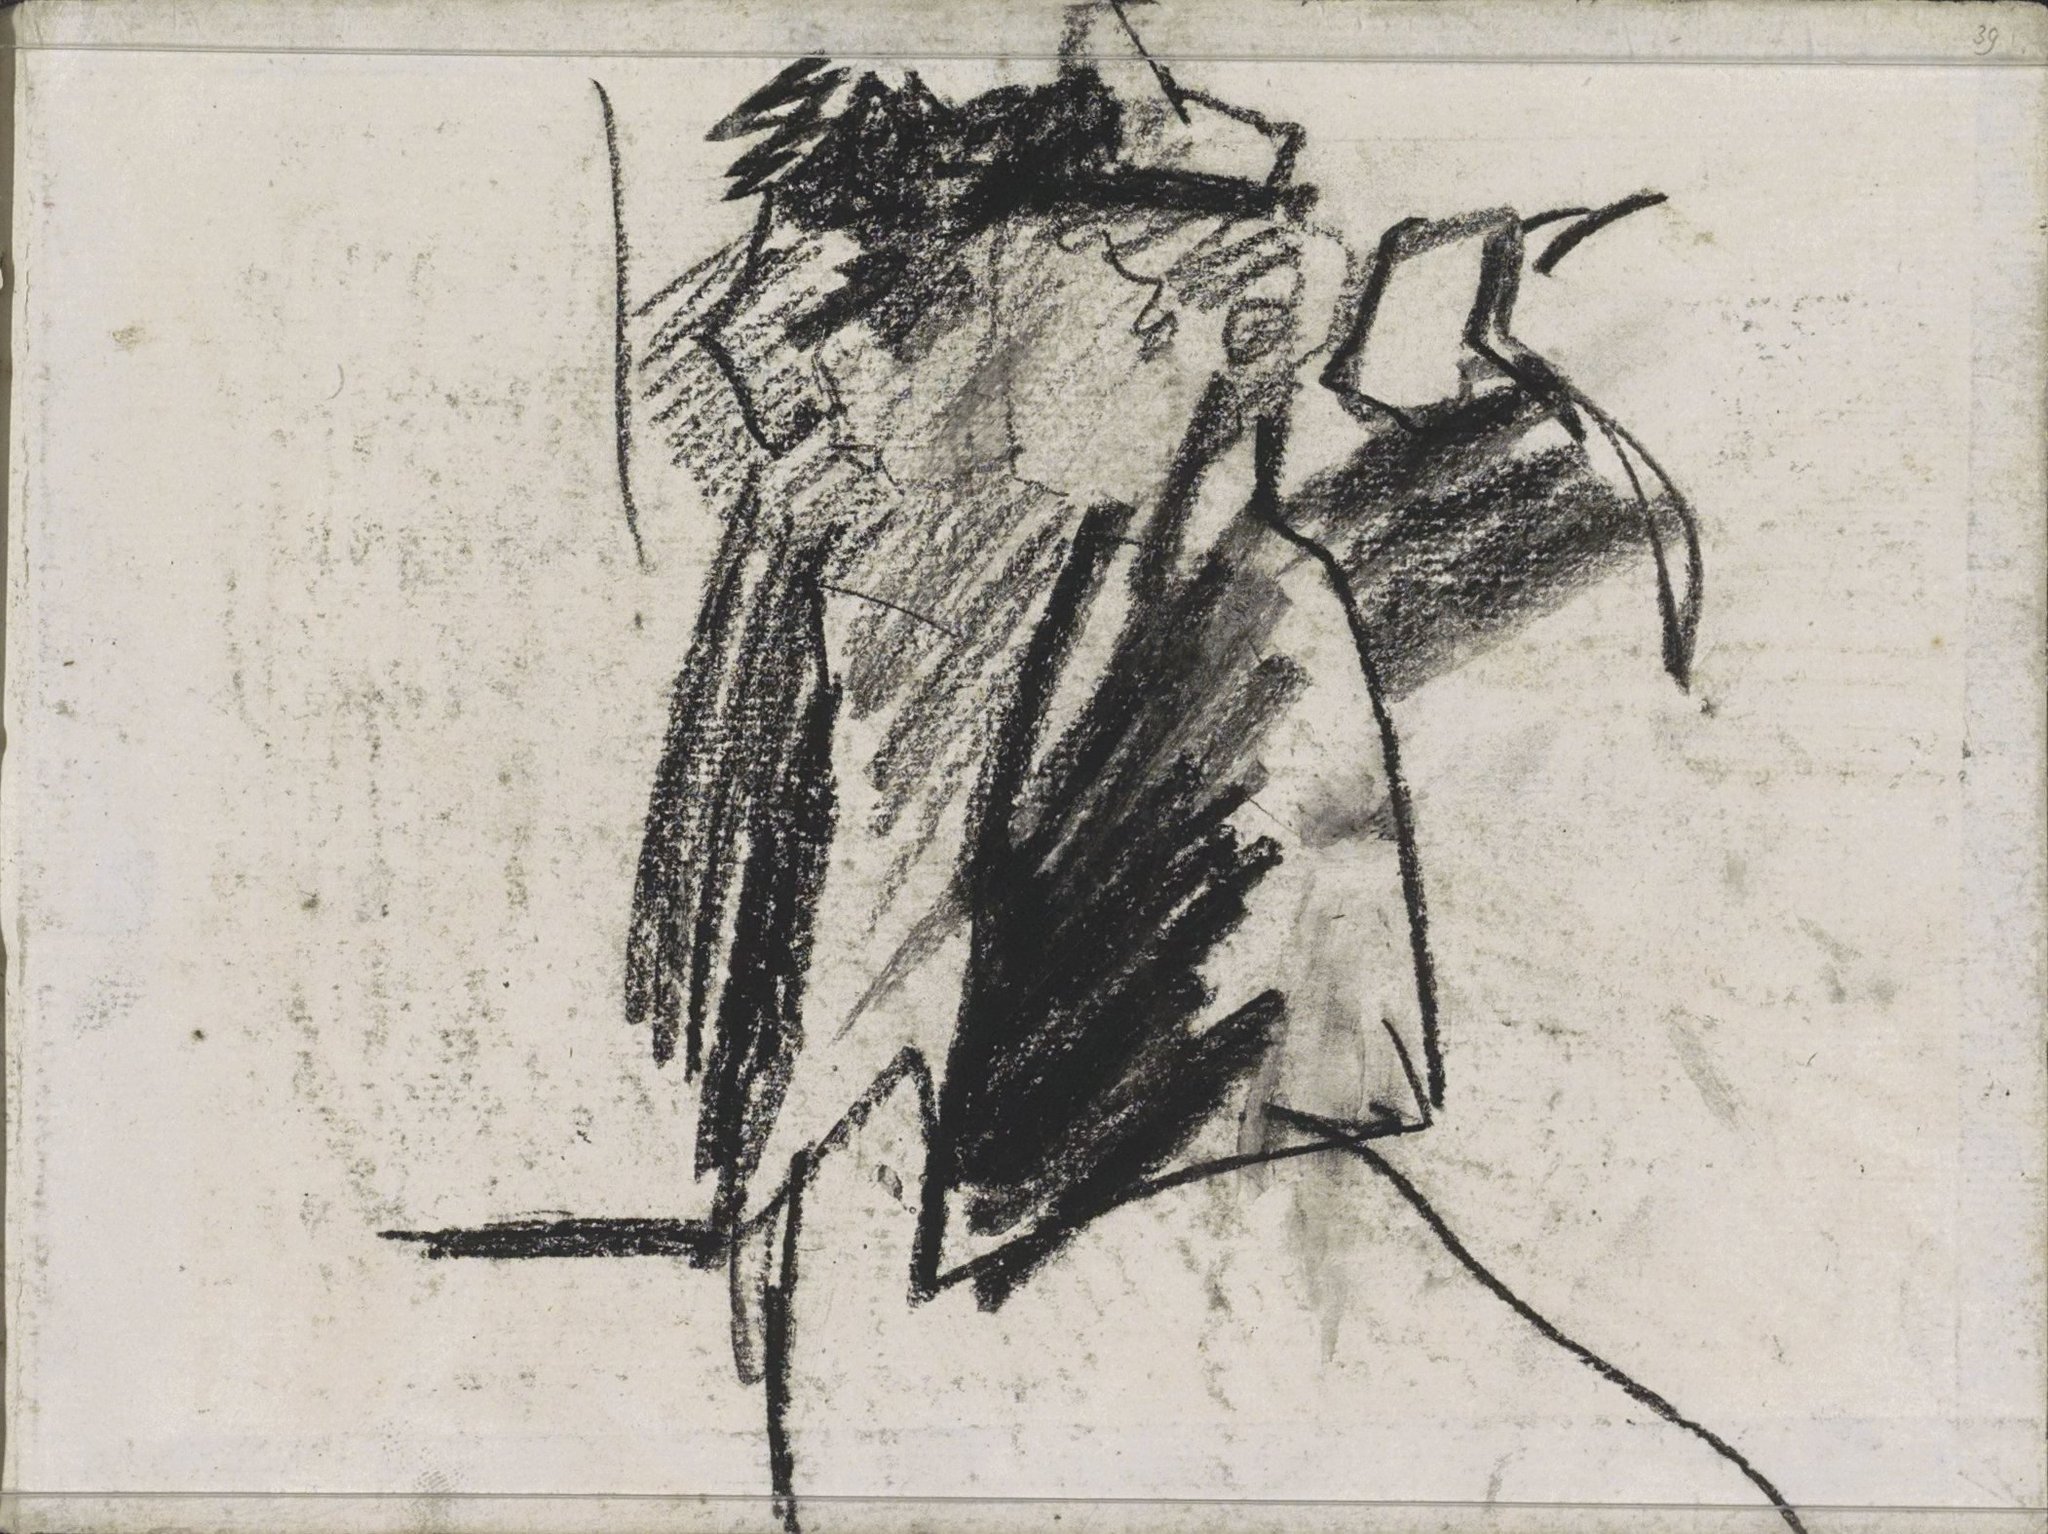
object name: endleaf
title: Groep vrouwen, mogelijk op straat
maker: isaac israels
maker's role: draughtsman, painter, print maker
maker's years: 1865-1934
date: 1875-1934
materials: chalk, paper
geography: the hague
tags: adult woman (+ sideview, profile), street (+ city(-scape) with figures, staffage)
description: Schutblad B, achterste schutblad, uit schetsboek XLI met 38 pagina's.